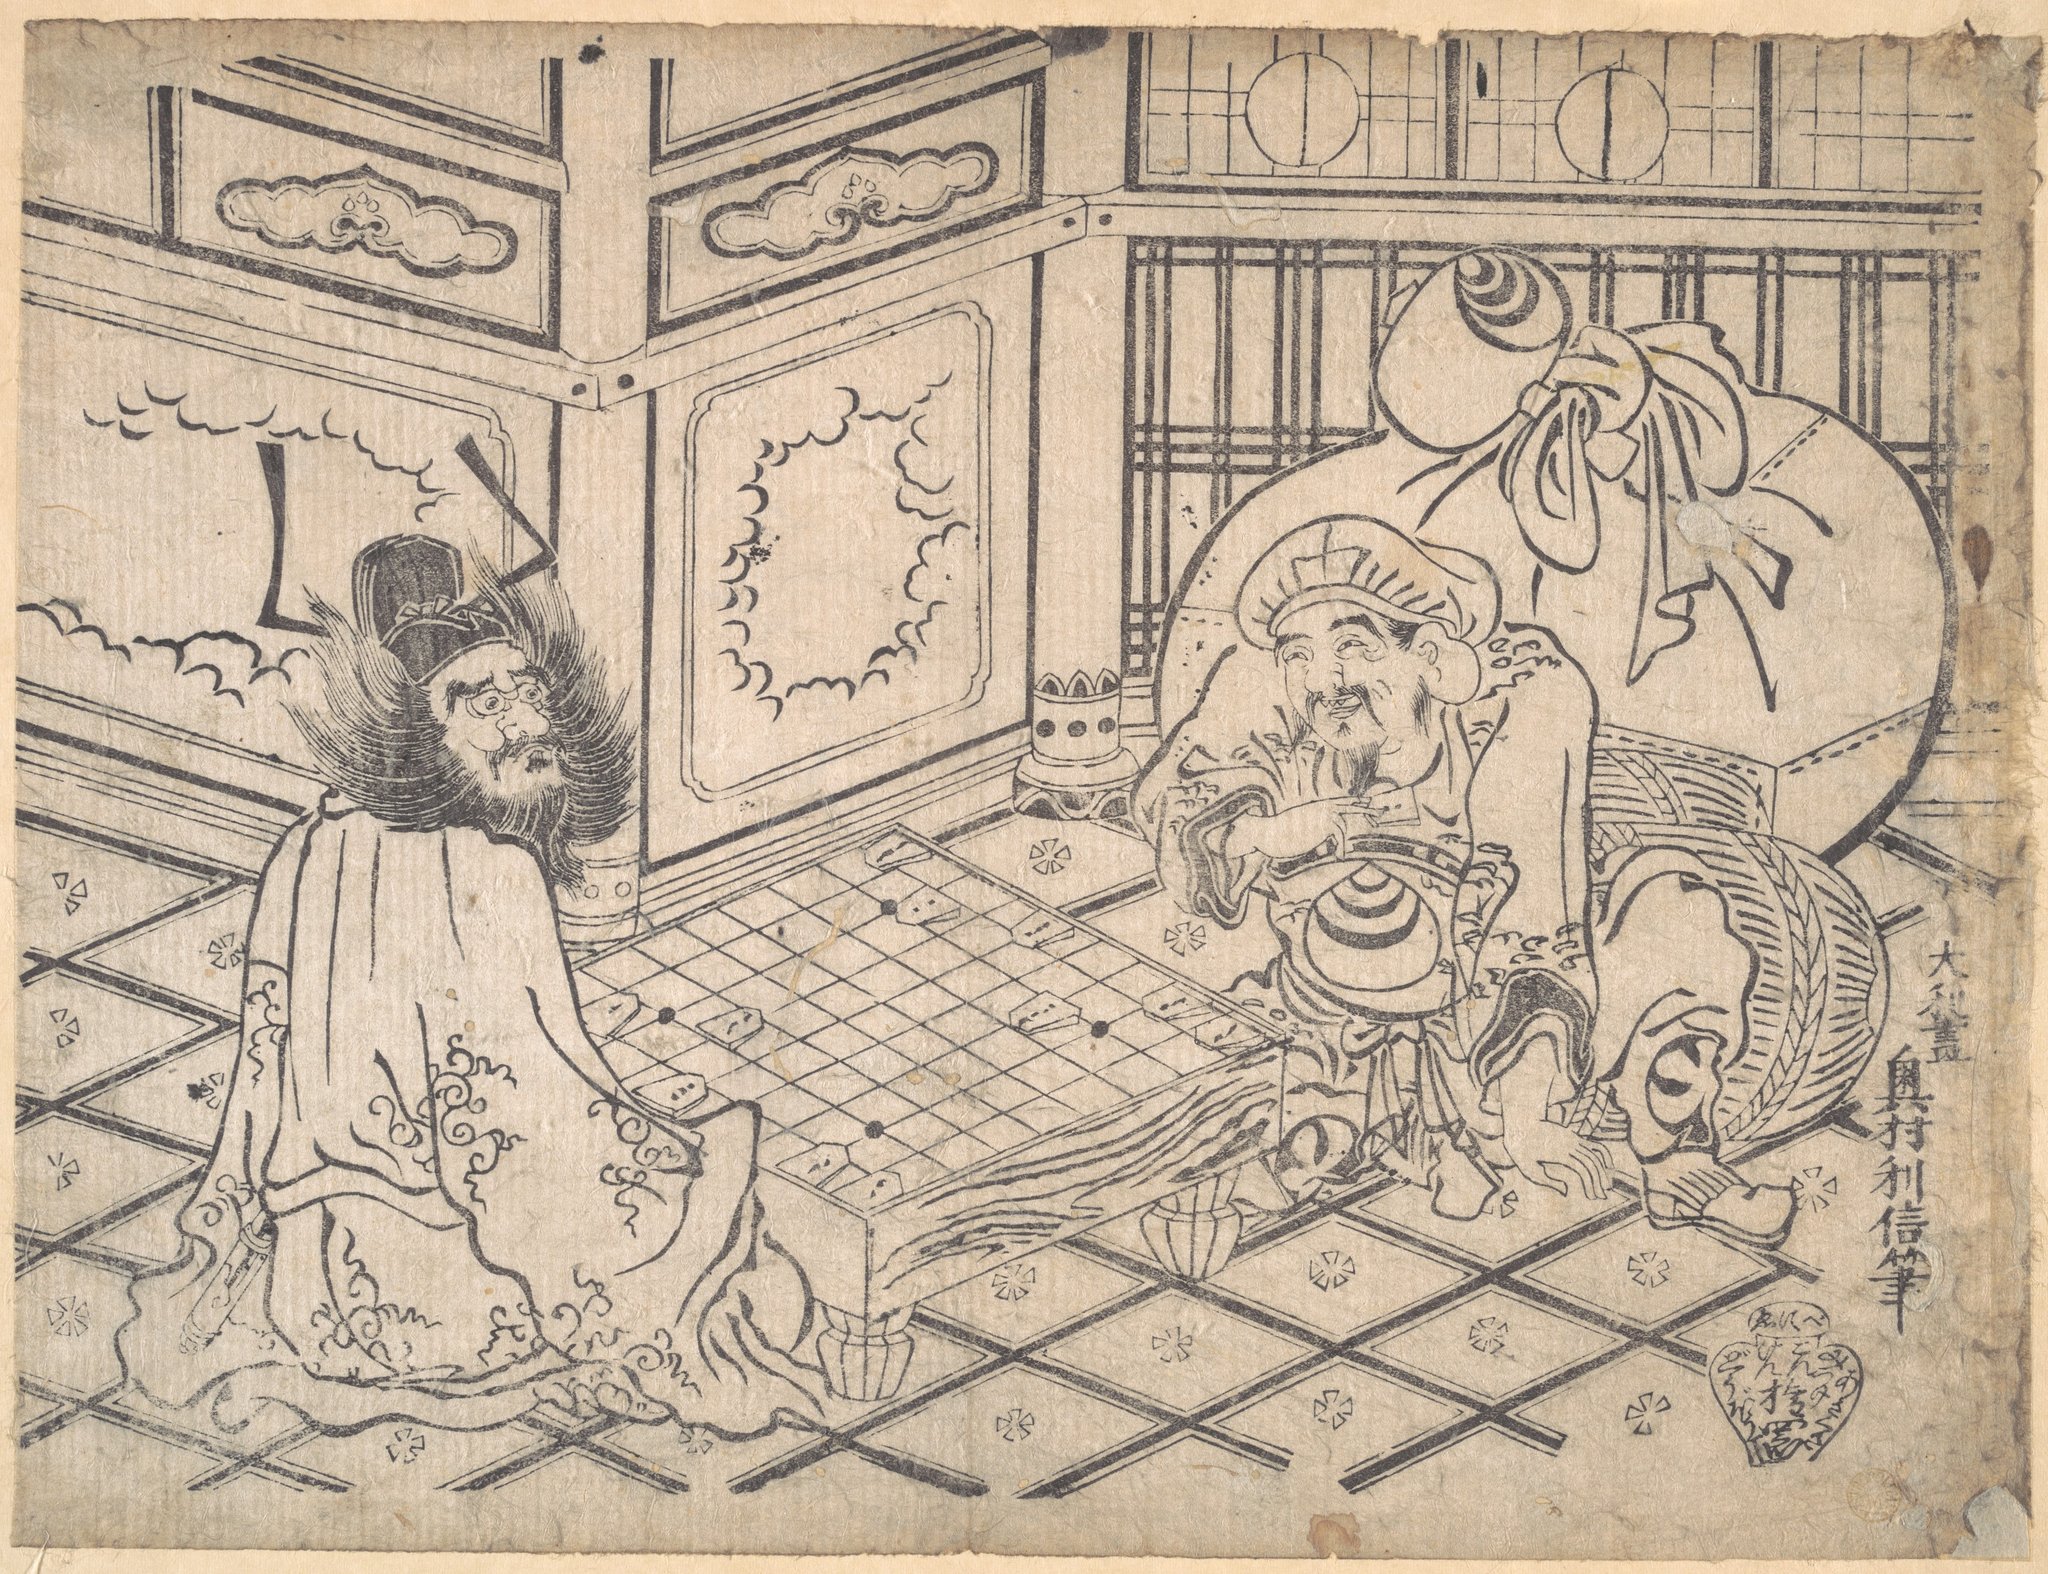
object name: print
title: Daikoku and Shoki Playing Chess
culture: japanese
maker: okumura toshinobu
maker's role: artist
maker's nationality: japanese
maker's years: 1717-1750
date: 1730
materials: ink, paper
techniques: woodblock print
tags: men,chess,games